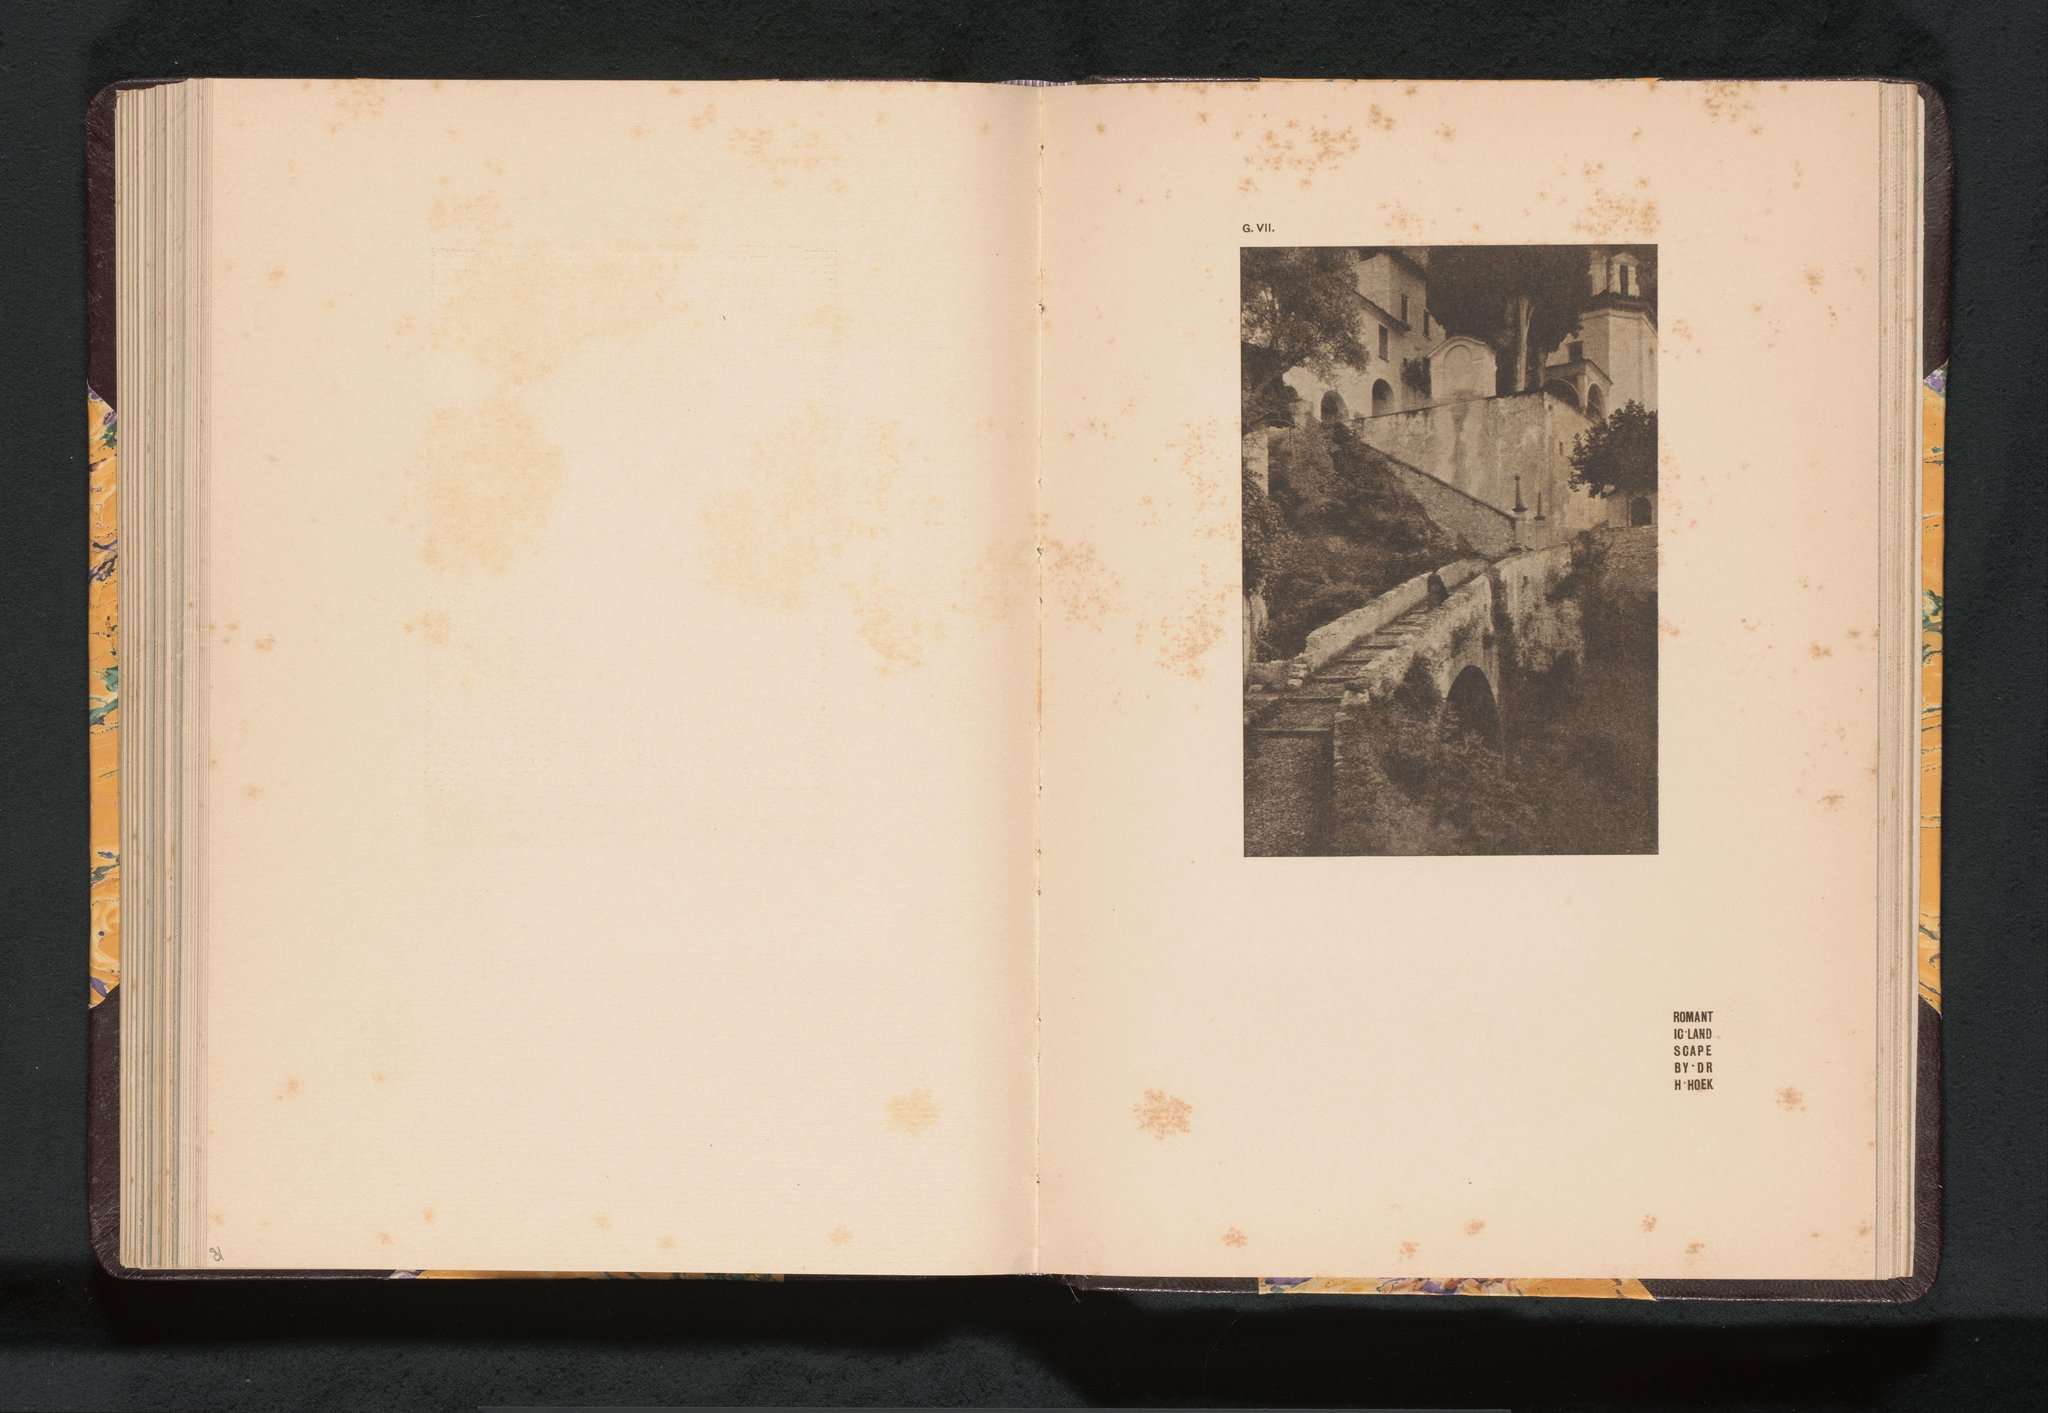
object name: photomechanical print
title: Stadsgezicht in de bergen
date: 1900-1905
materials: paper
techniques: autotype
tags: city-view in general; 'veduta'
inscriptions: inscription: ‘G. VII.’, inscription: ‘Romantic Landscape by Dr. H. Hoek’